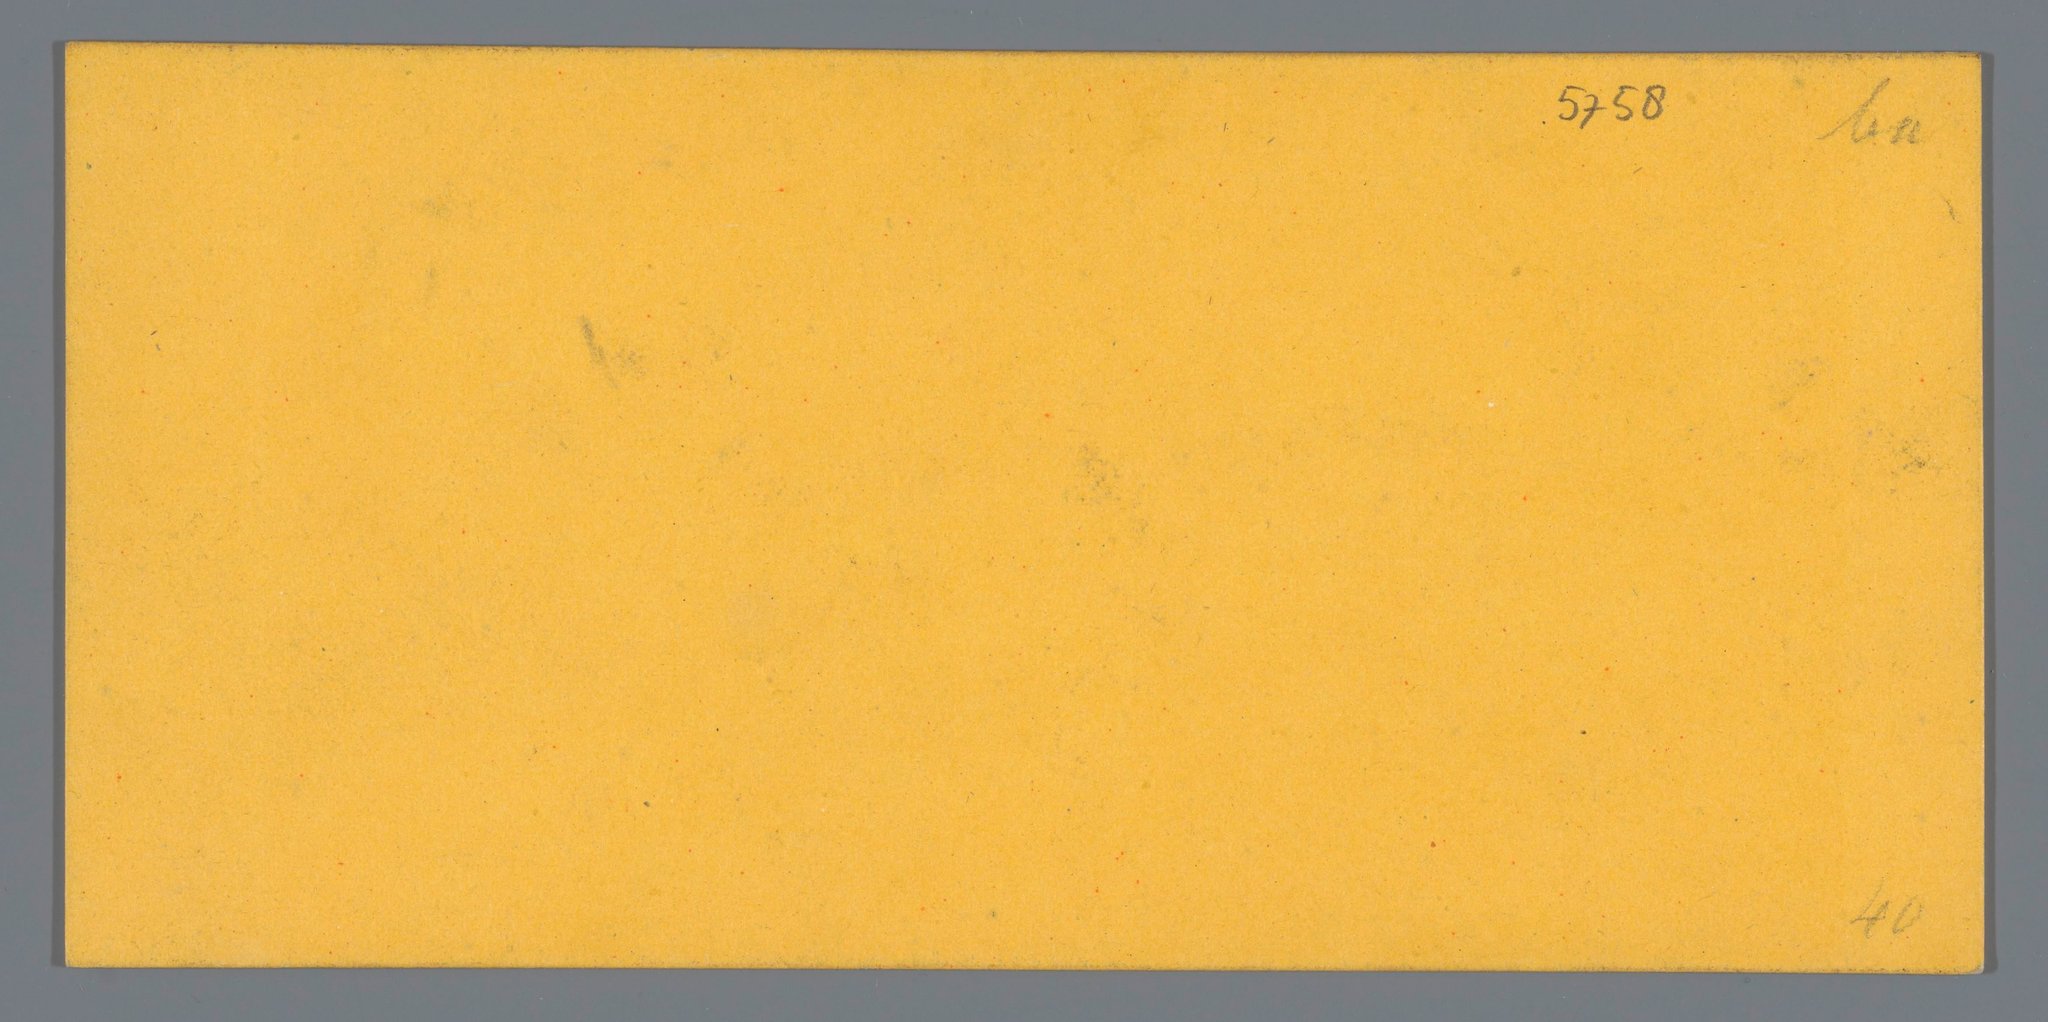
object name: stereograph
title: Hotel de Ville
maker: Anonymous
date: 1850-1880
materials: cardboard, photographic support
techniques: albumen print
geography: paris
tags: townhall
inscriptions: number: ‘40’